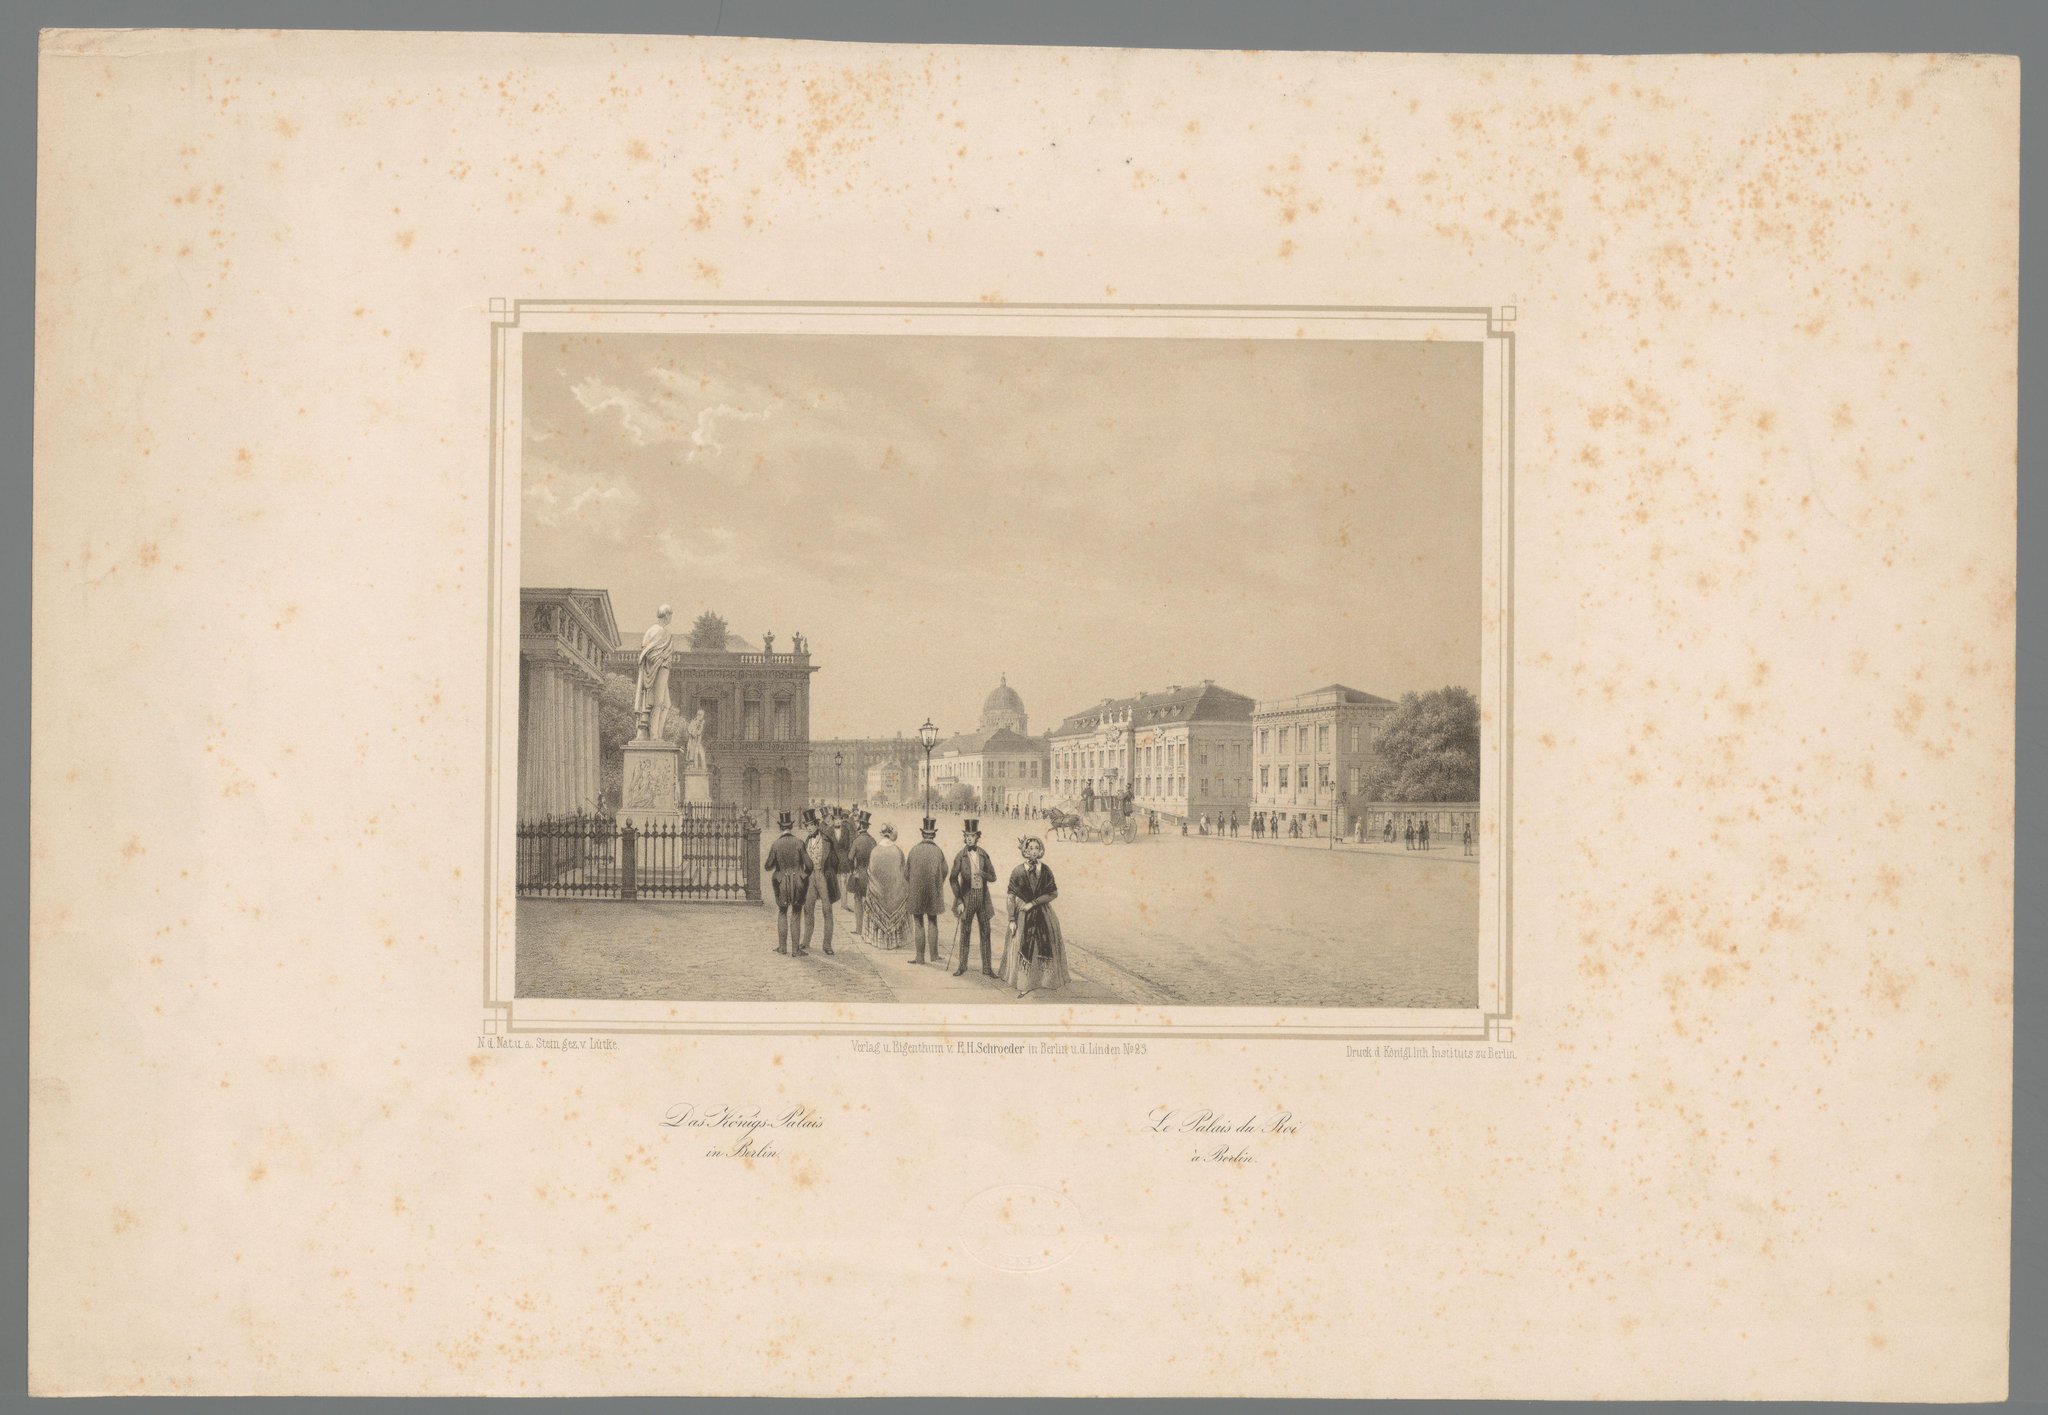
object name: print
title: Landschappen en stadsgezichten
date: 1840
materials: paper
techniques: tone lithography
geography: berlin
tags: hôtel, i.e. small palace in city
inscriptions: check stamp: ‘Buch u. Kunsth. von E.H. Schroeder in Berlin’, collector's mark: Lugt 2233